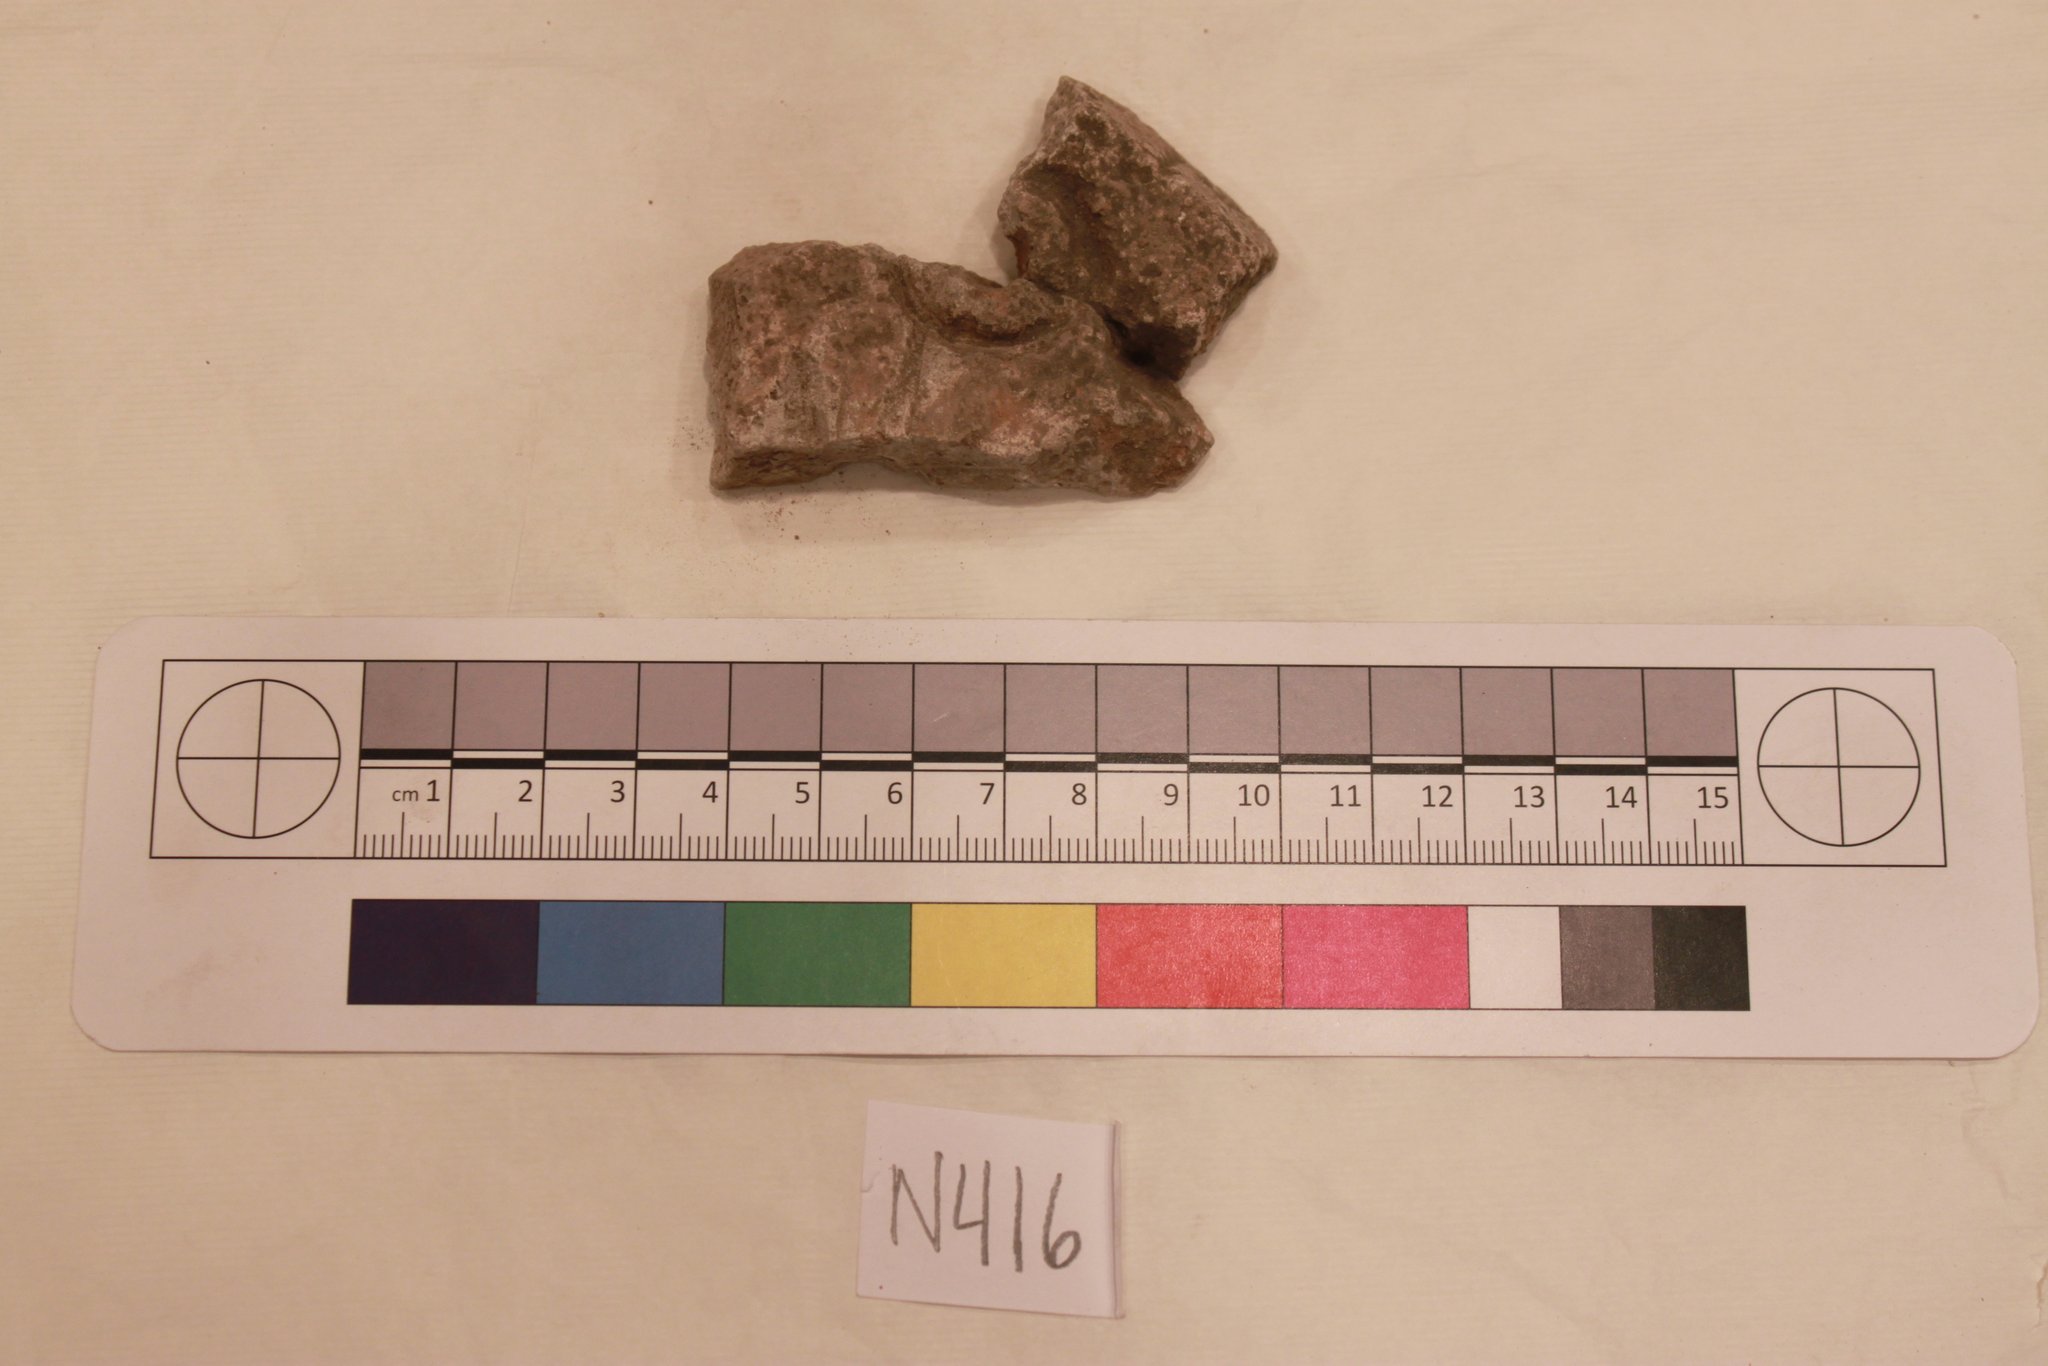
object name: fragment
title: Stucco Fragment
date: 701-1200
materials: plaster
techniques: carving, painting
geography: iran